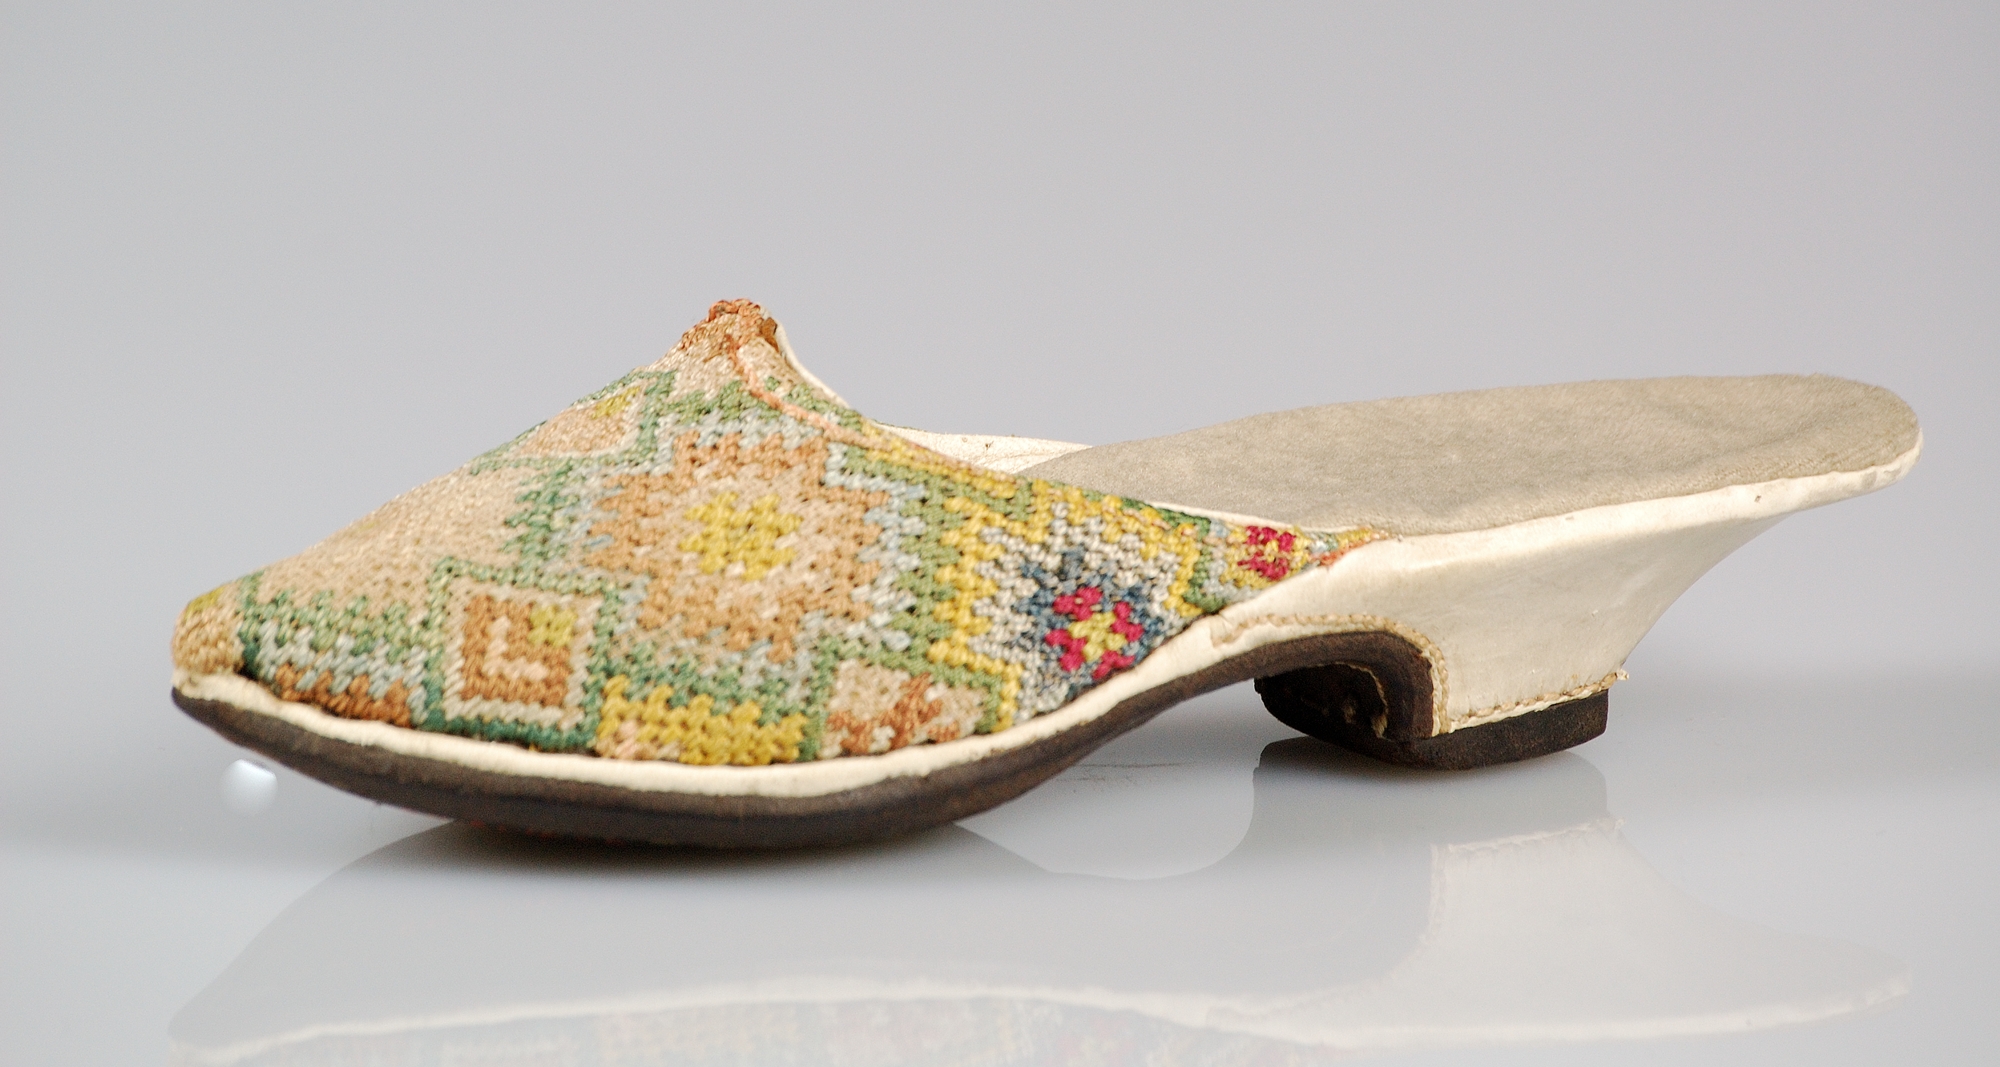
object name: mule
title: Mules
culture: european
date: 1701-1733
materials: leather, linen, silk